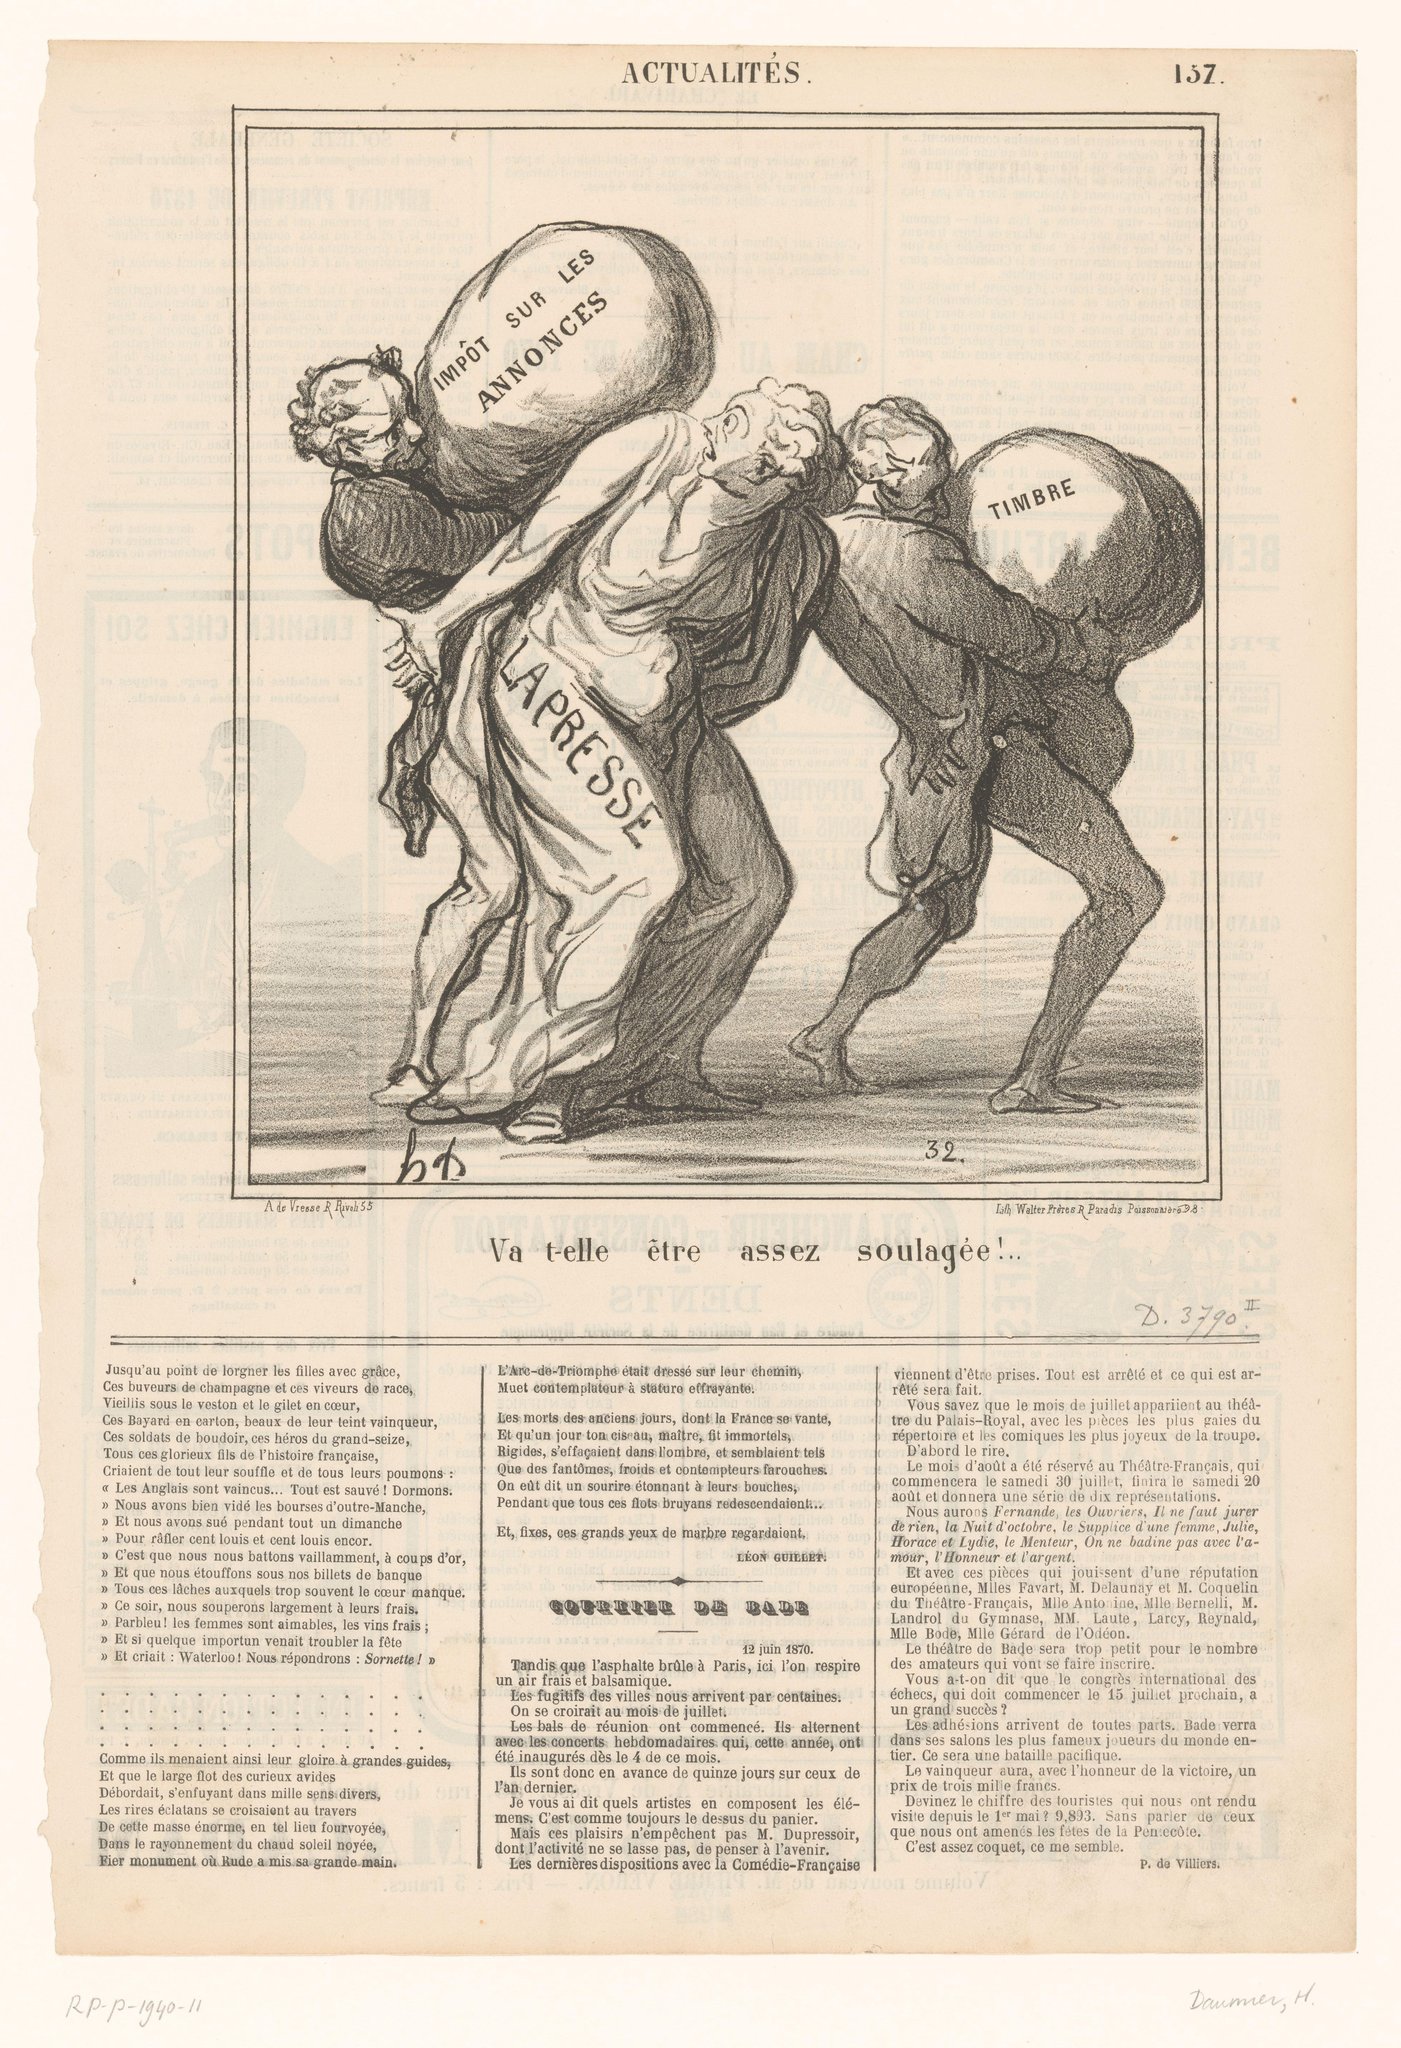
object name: cartoon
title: Actualités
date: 1870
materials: paper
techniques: lithograph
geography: paris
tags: press, journalism, political caricatures and satires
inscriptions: collector's mark: Lugt 2166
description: Prent gebruikt voor: Le Charivari, 17 juni 1870.